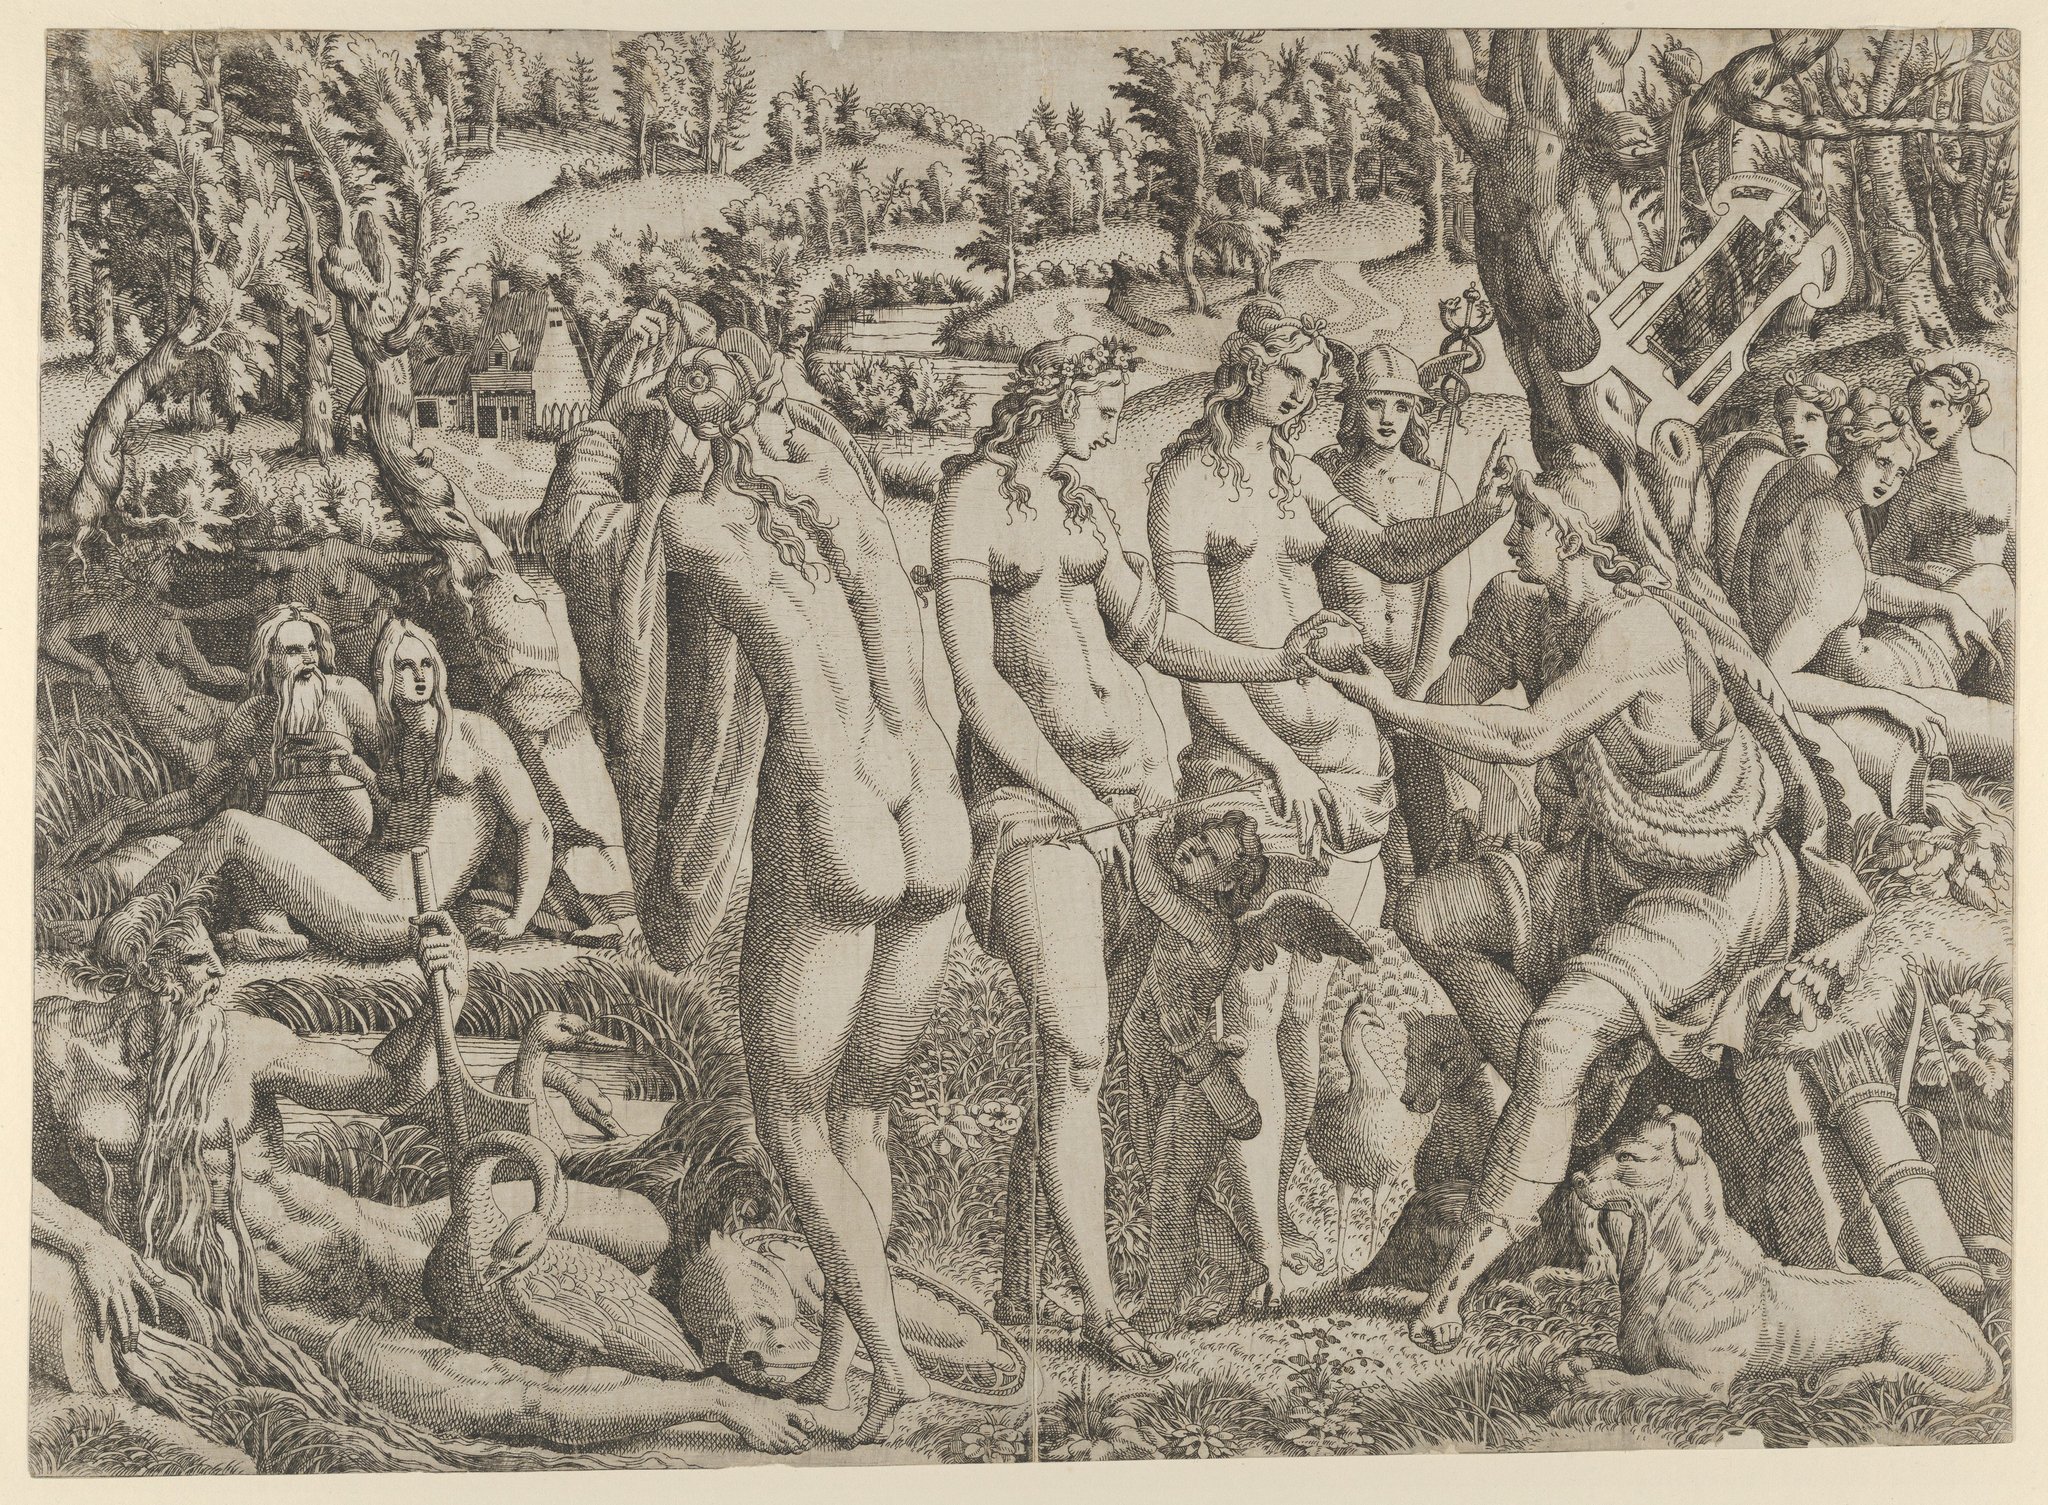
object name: print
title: The Judgment of Paris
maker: jean mignon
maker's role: artist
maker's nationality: french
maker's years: 1535-1555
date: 1535-1555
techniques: etching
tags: animals,birds,male nudes,female nudes,trees